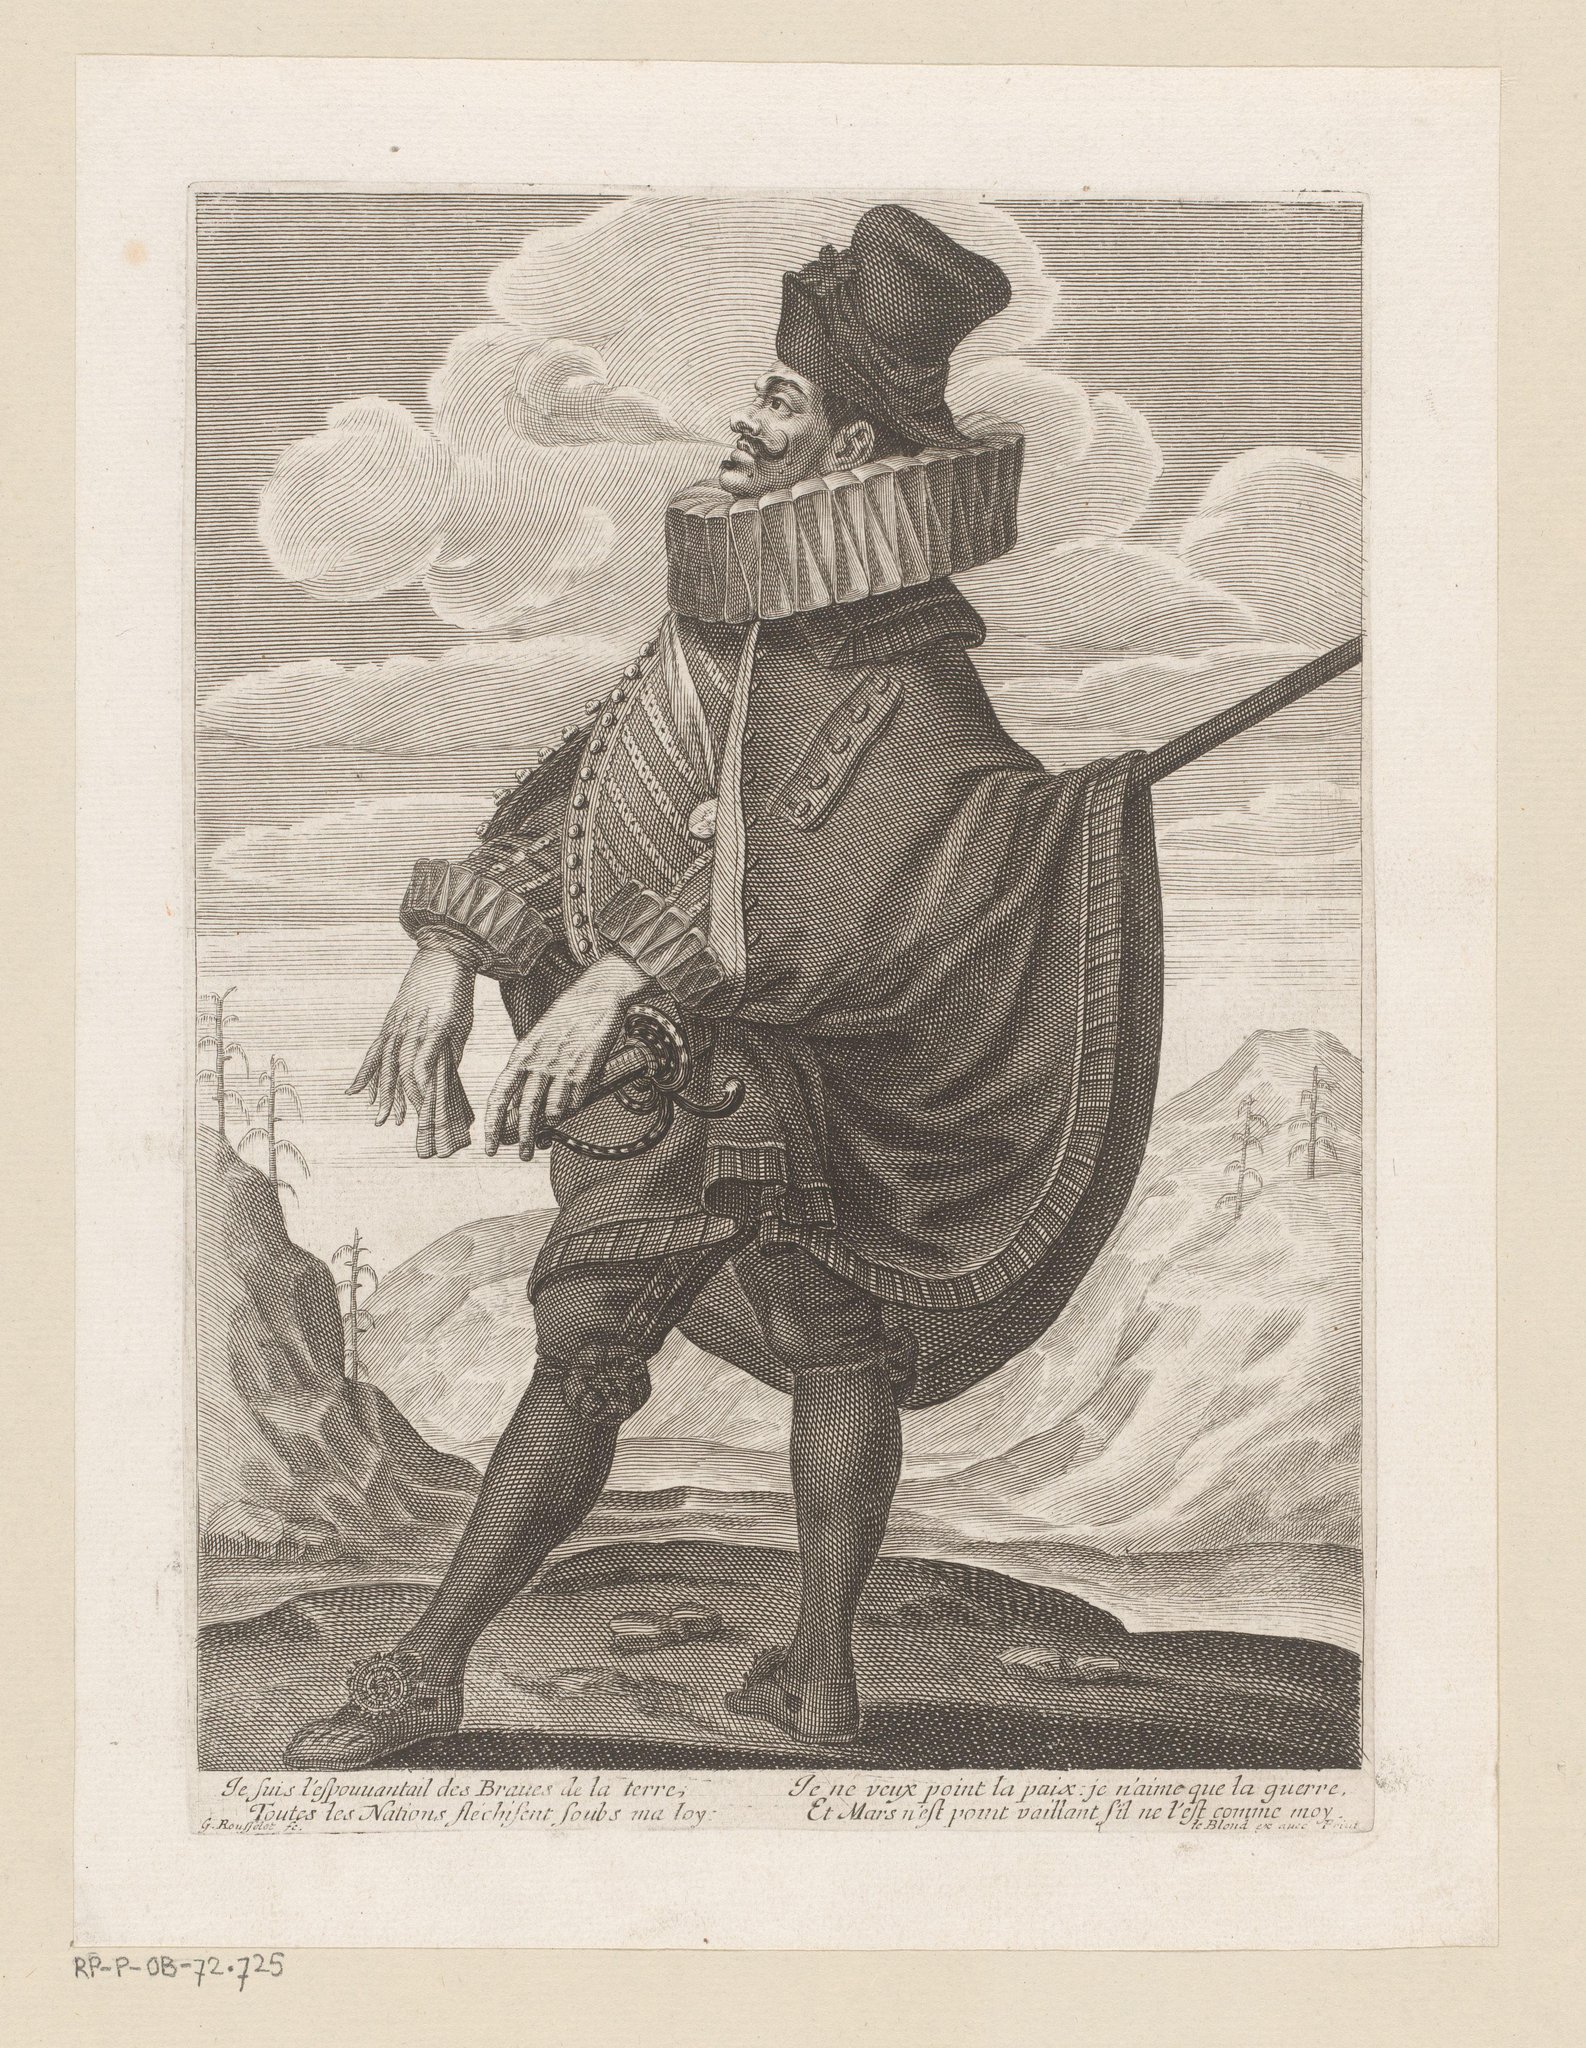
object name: print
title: Spaanse kapitein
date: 1645-1686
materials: paper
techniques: engraving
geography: france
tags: neck-gear ~ clothing (with name) (+ men's clothes), adult man, land forces, clothes, costume (+ men's clothes)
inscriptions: collector's mark: Lugt 1838, collector's mark: Lugt 240